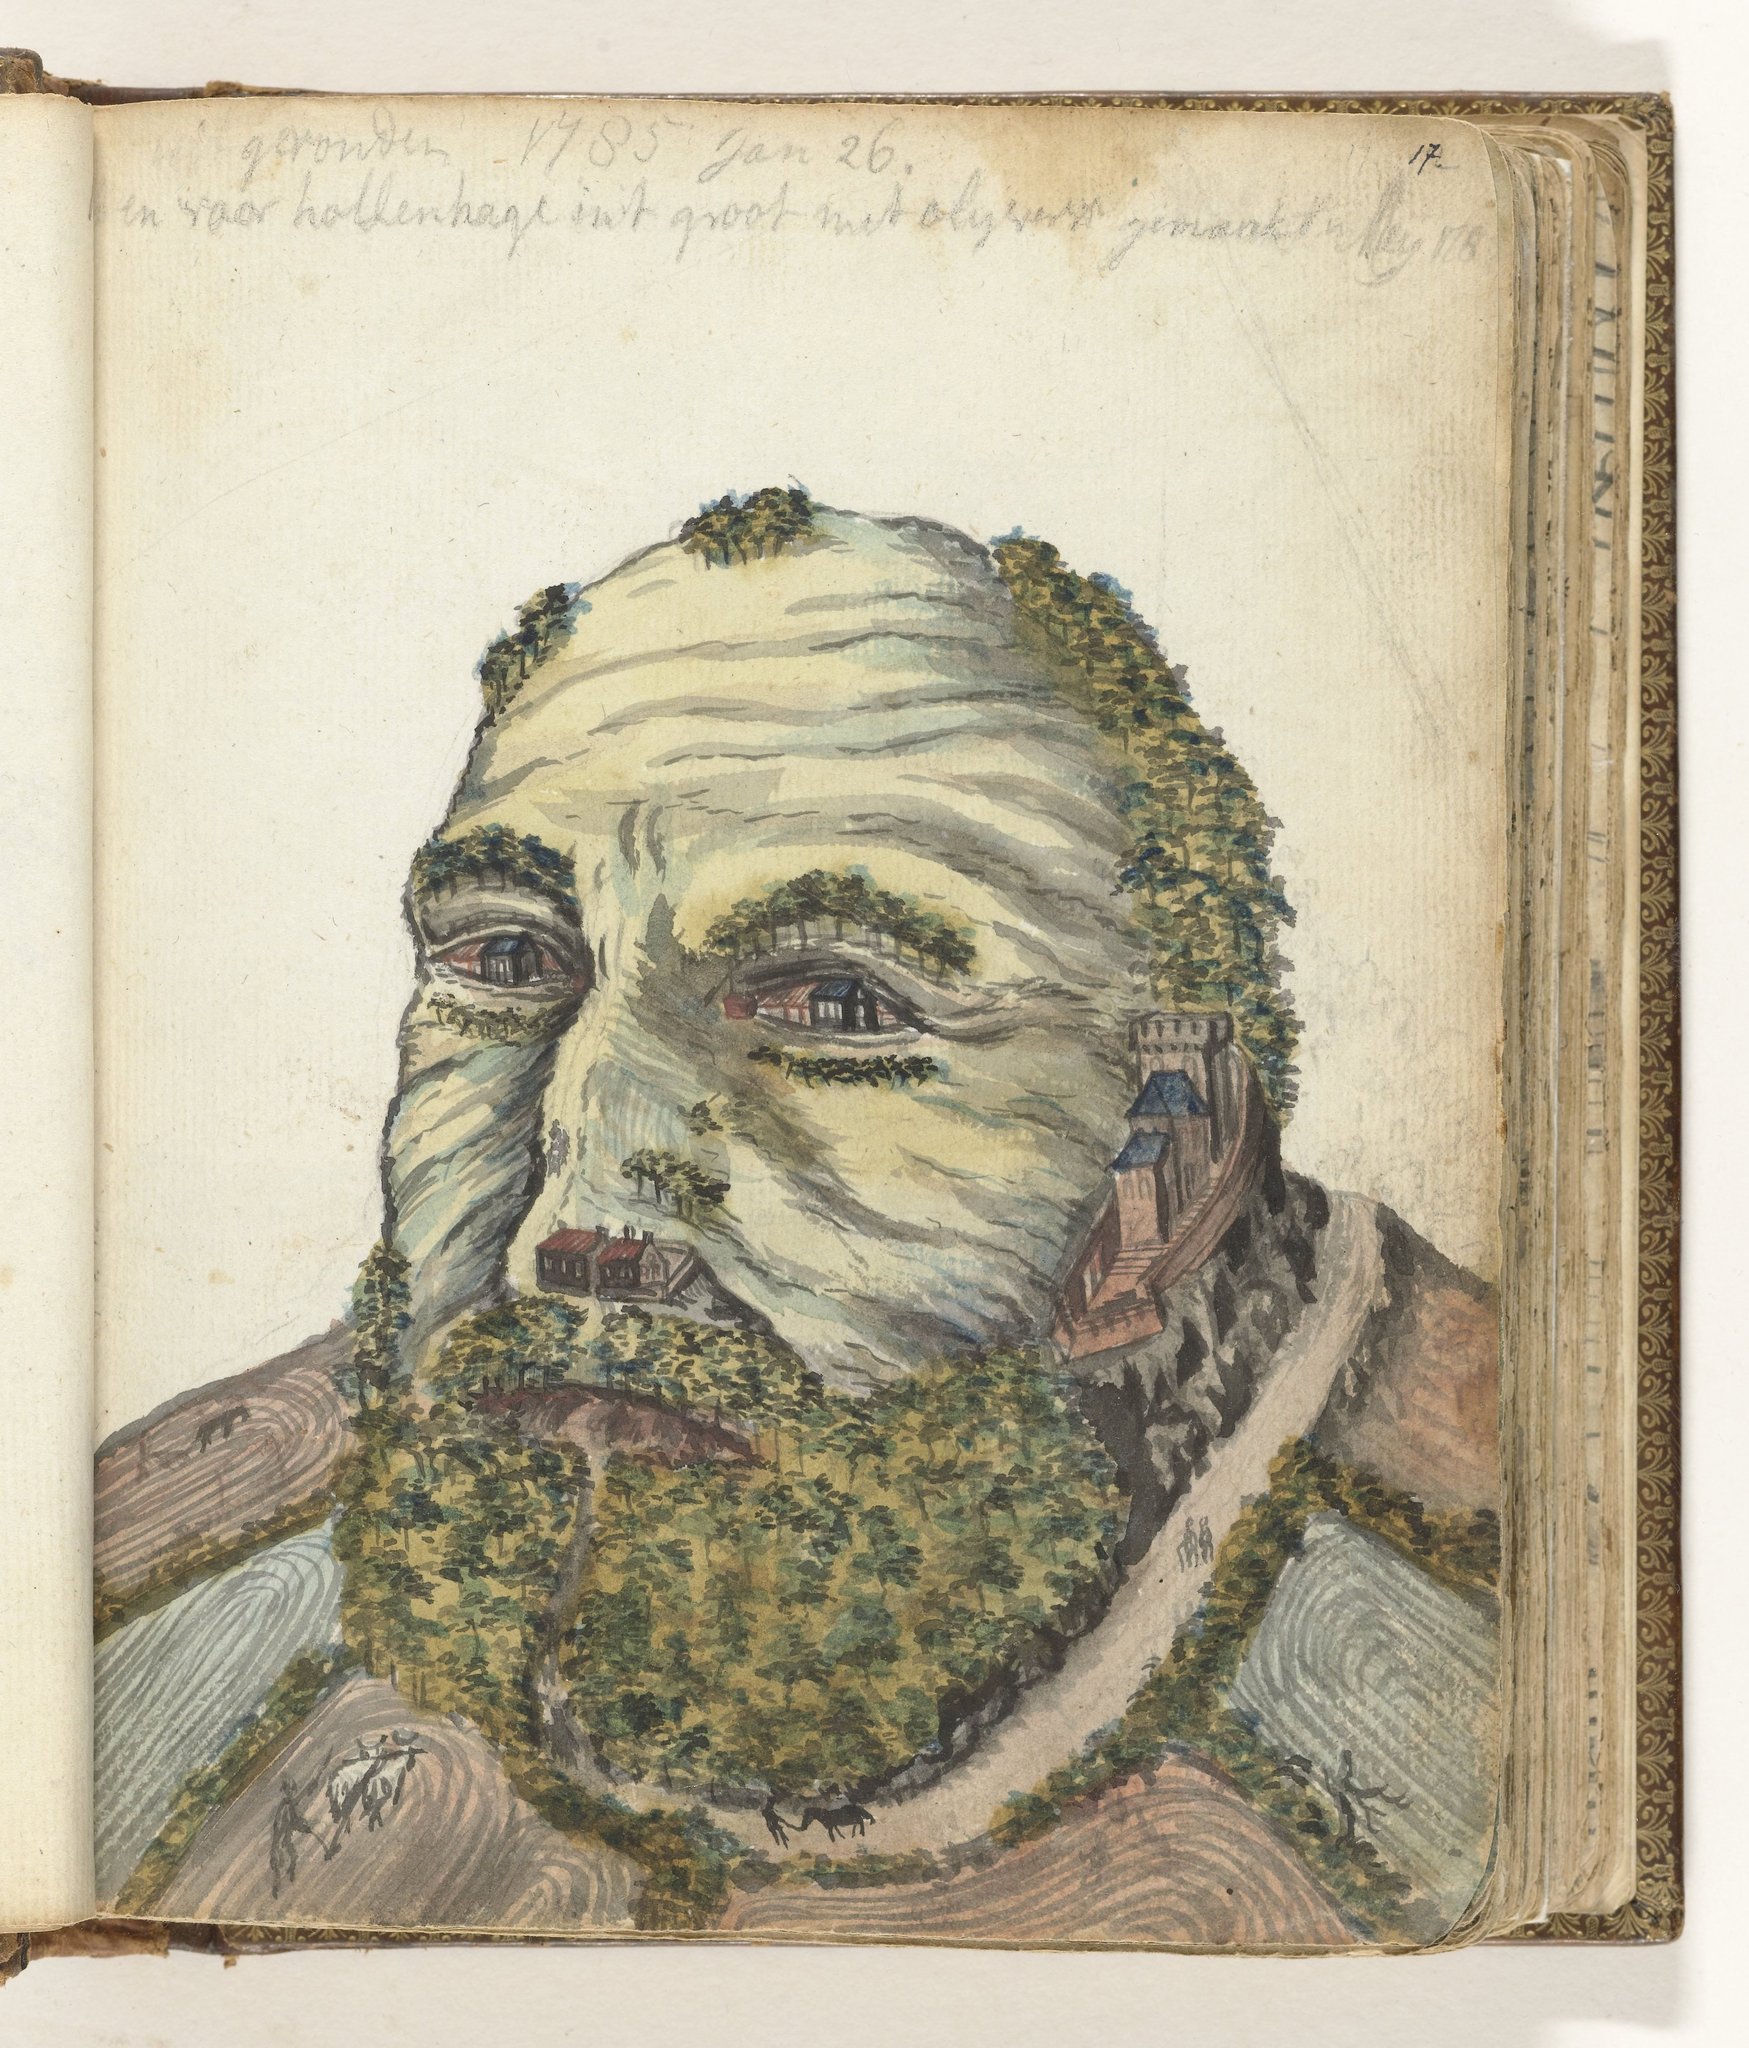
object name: drawing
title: Antropomorphe Hill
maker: jan brandes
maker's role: draughtsman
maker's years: 1743-1808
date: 1785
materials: paper, pencil, watercolor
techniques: brush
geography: jakarta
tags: mountains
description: Kleurtekening van een berg met menselijke trekken. De tekenaar heeft hiervan een olieverfschilderij gemaakt. Met opschrift. Onderdeel uit het schetsboek van Jan Brandes, dl. 2 (1808), p. 17.